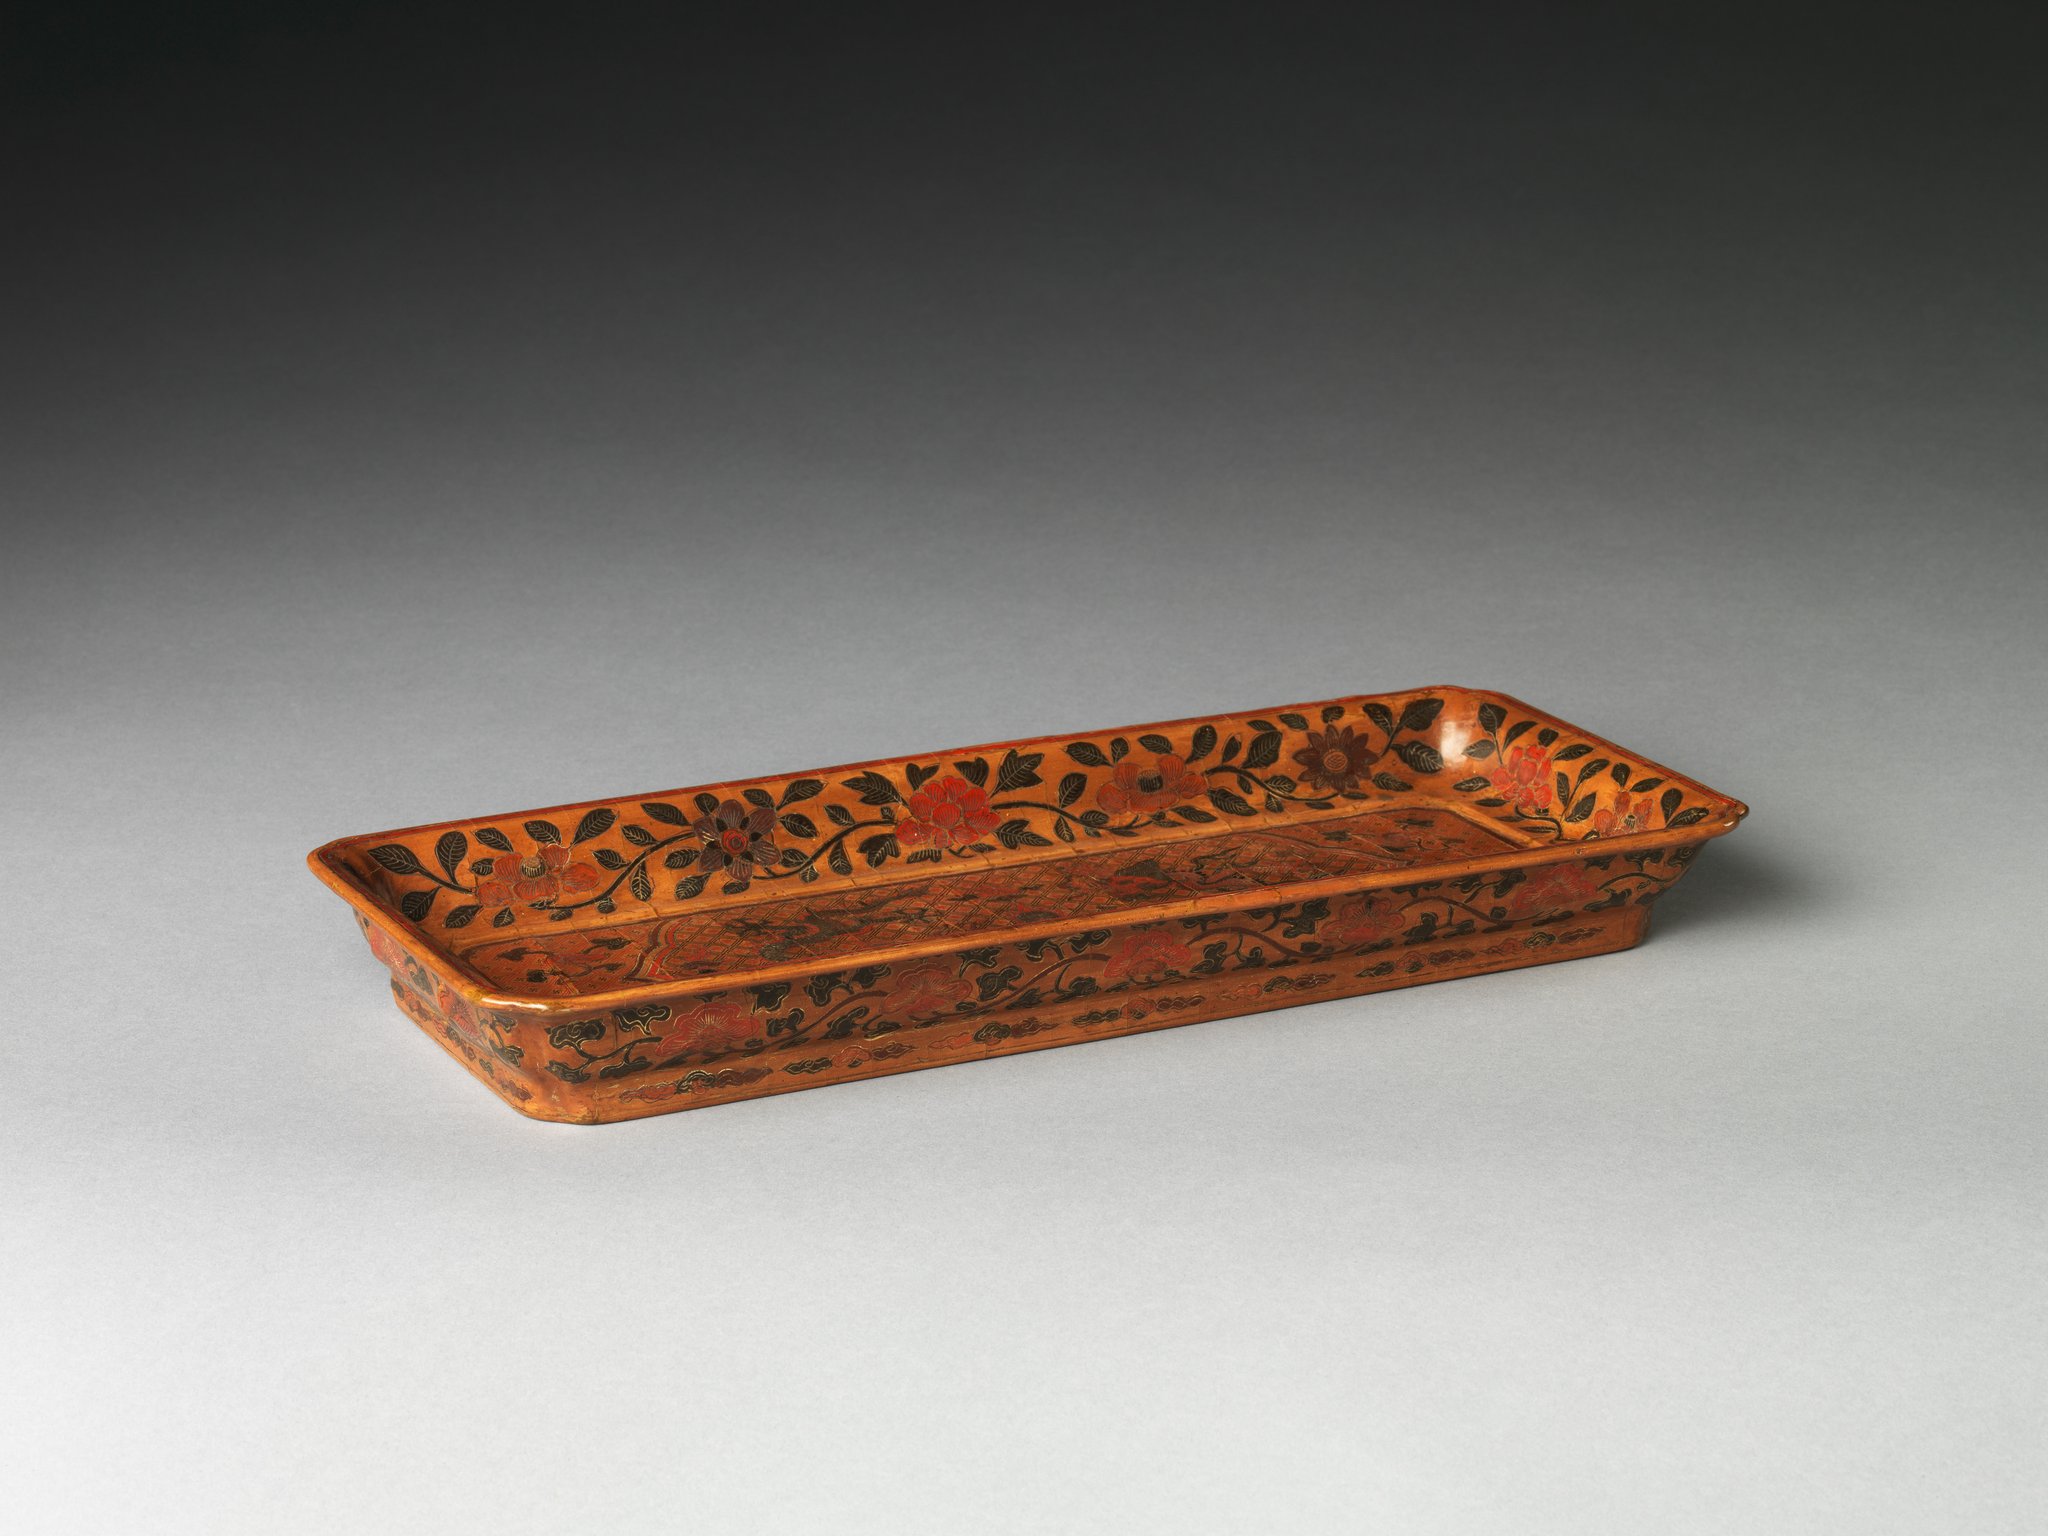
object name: tray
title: Rectangular tray with double dragons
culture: chinese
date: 1567-1633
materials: gold, lacquer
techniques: engraving, polychrome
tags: dragons